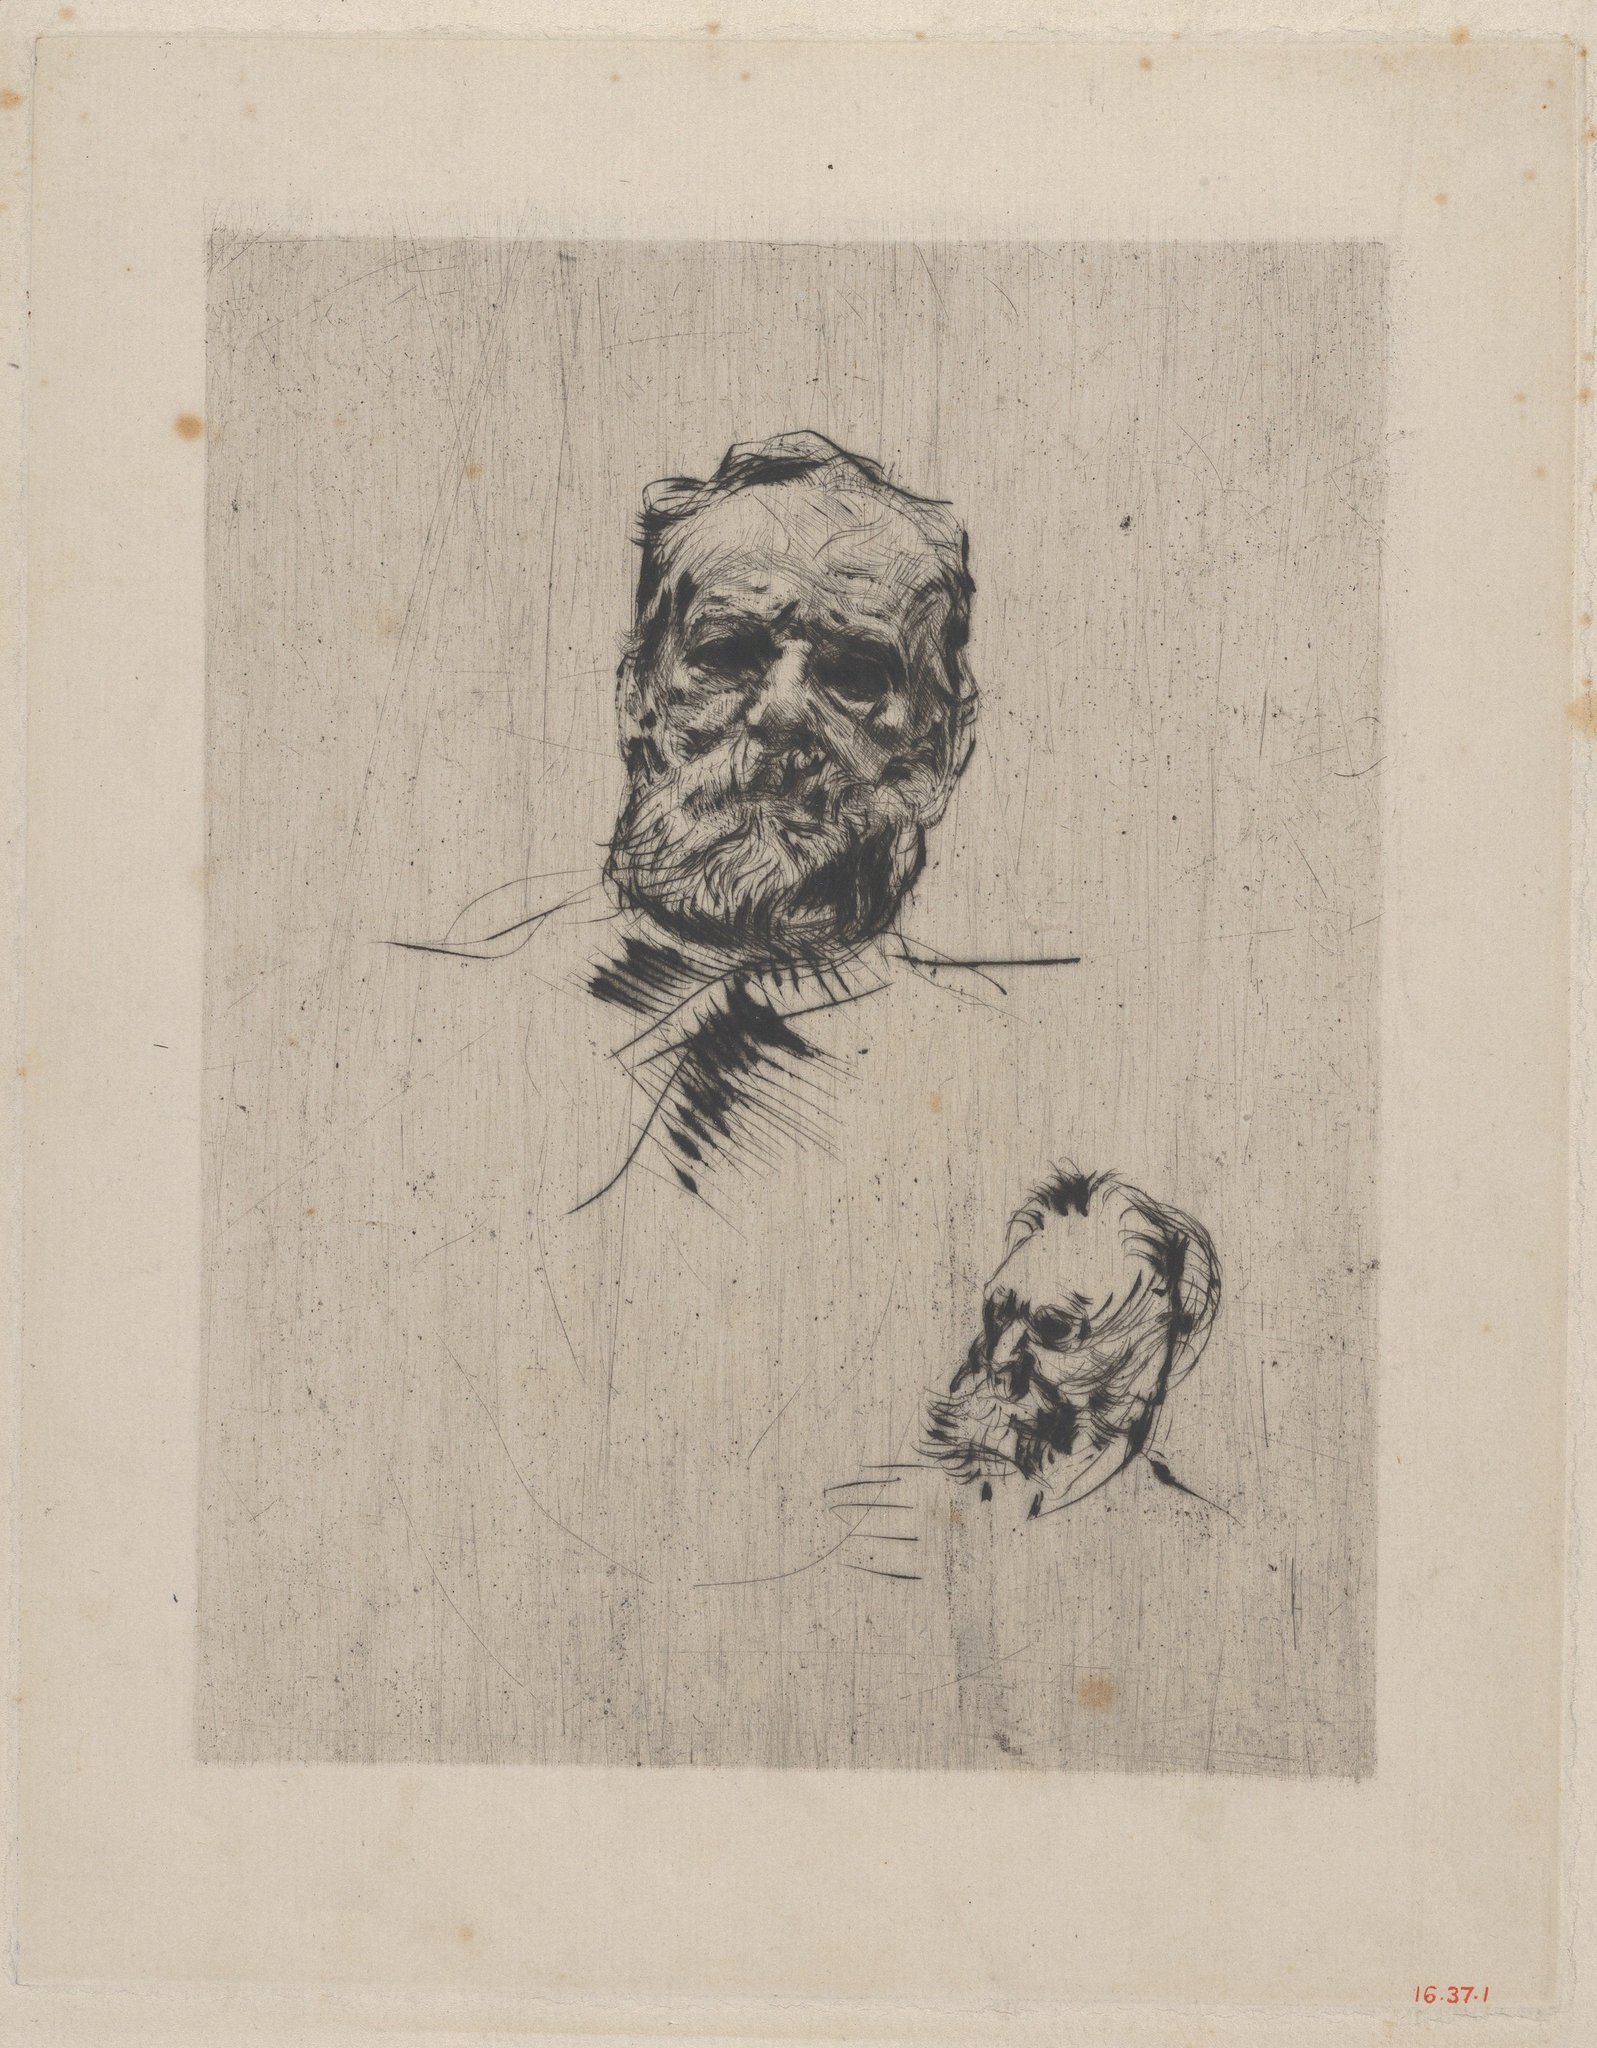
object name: print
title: Victor Hugo (full face)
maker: auguste rodin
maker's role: artist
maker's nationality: french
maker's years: 1840-1917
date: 1885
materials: paper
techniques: drypoint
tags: faces,men,poets